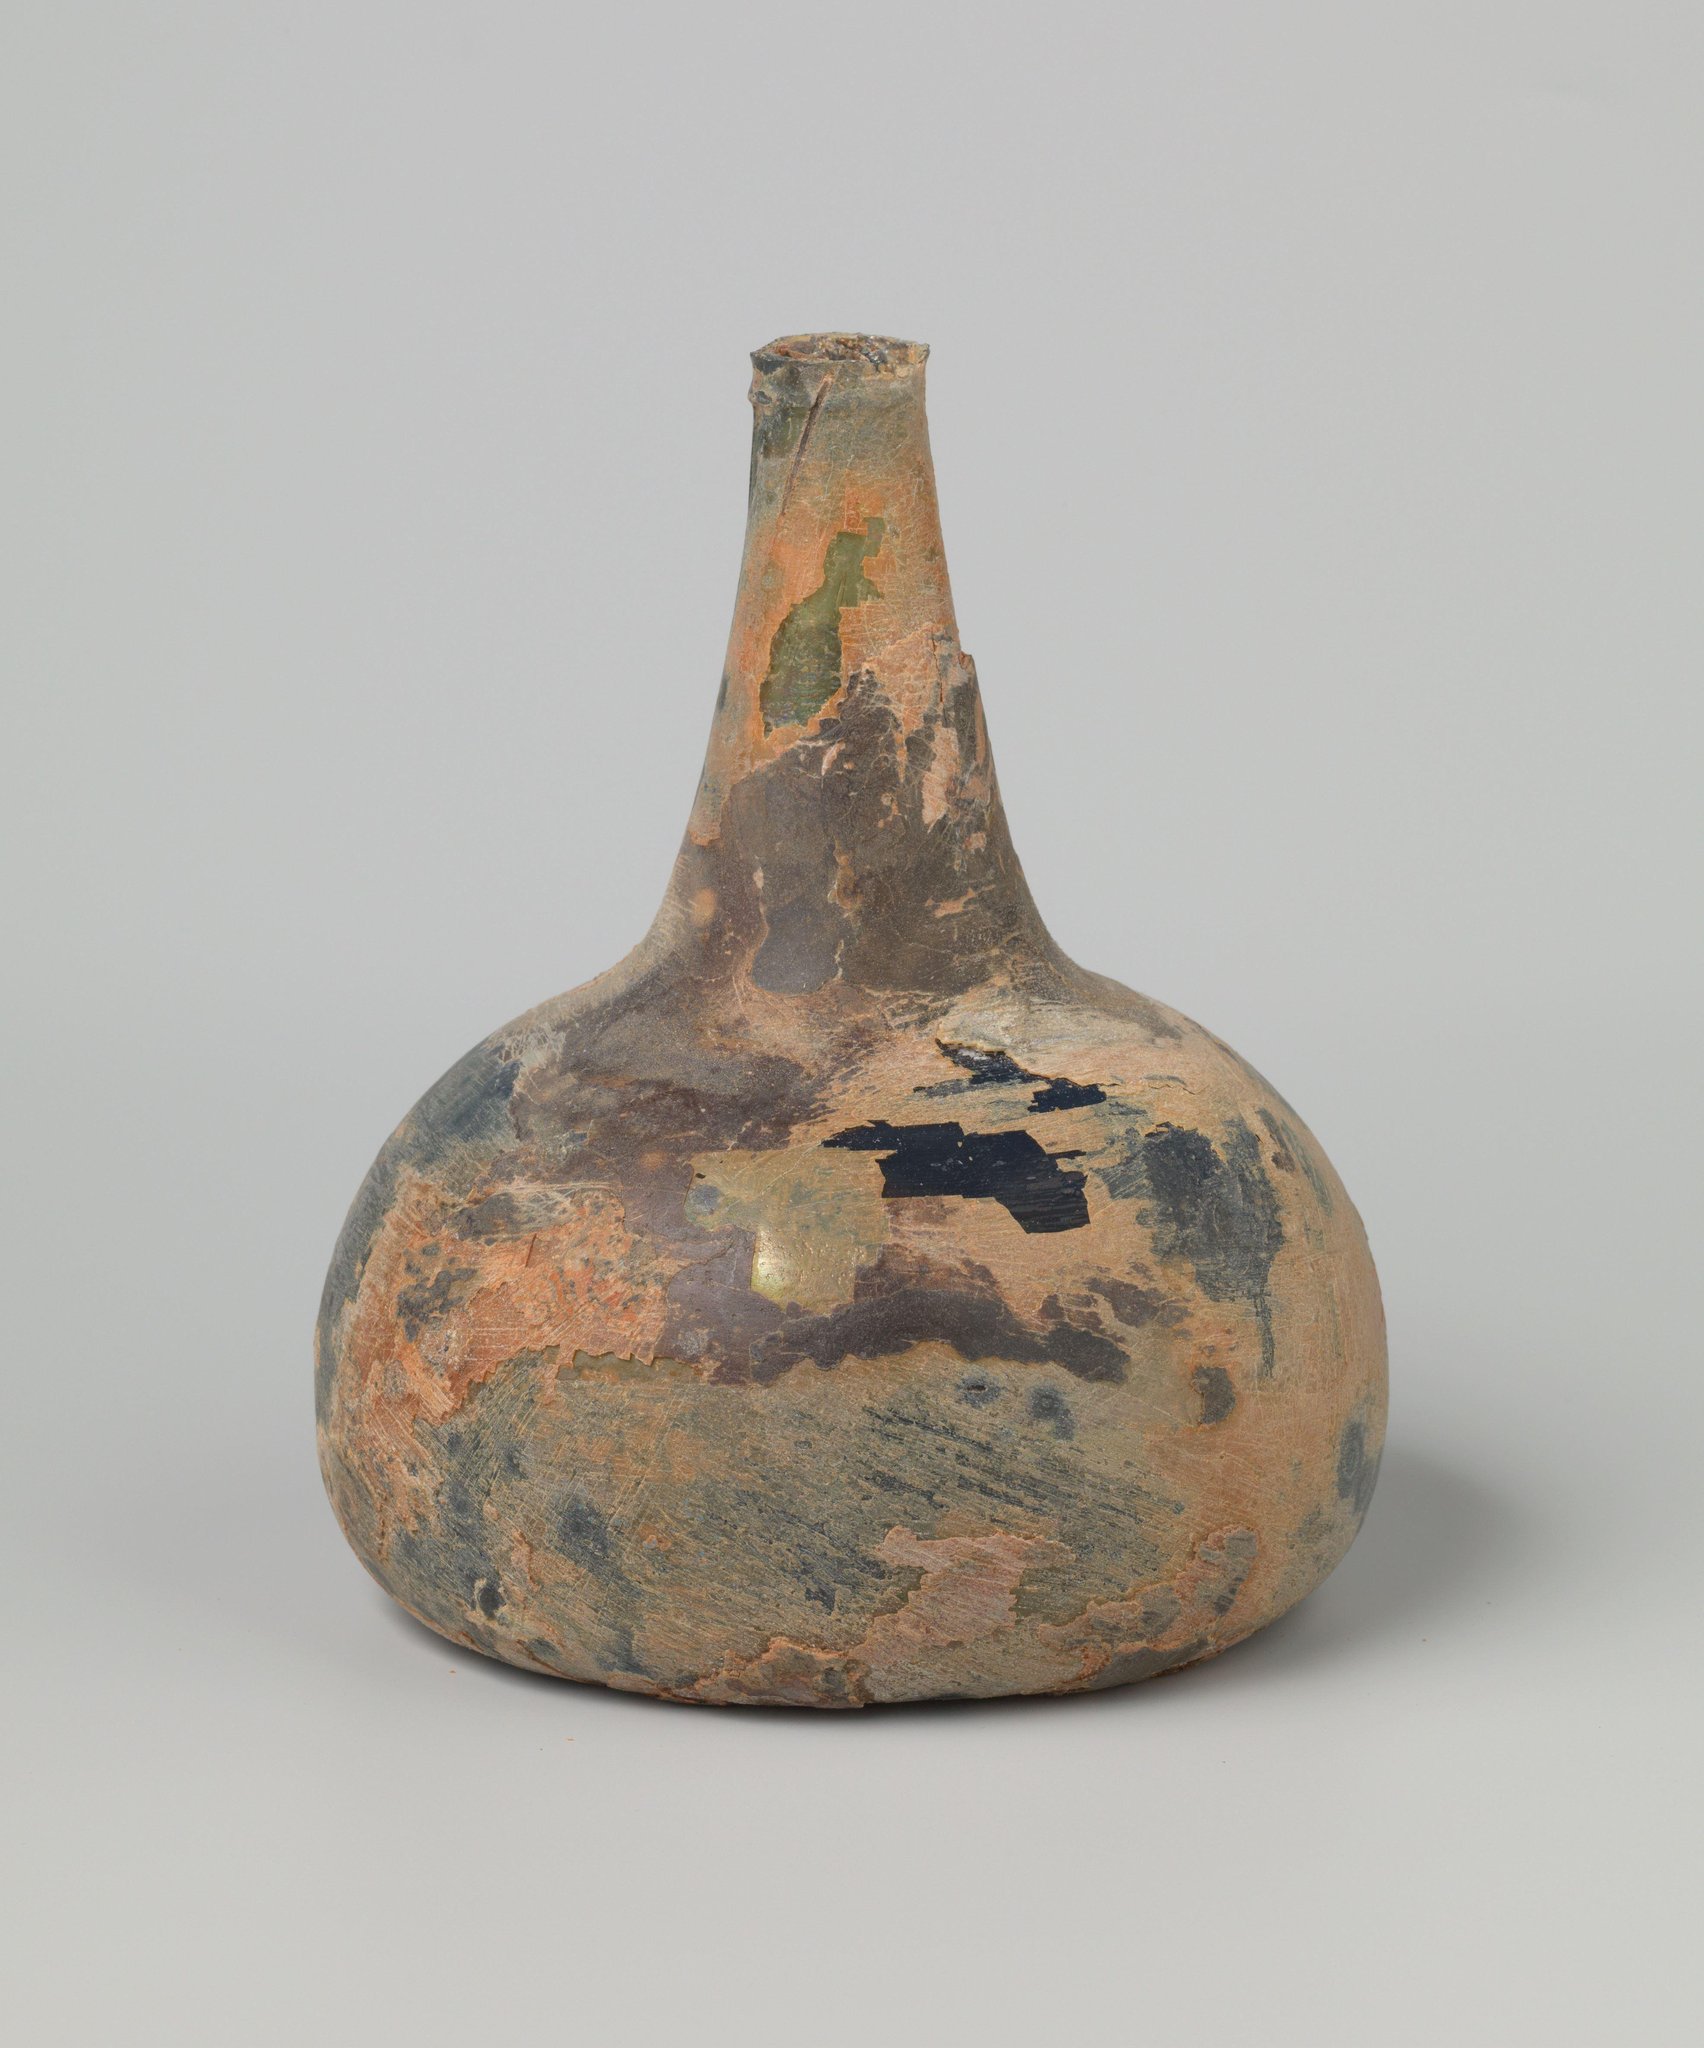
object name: wine bottle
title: Wijnfles uit het wrak van de Oost-Indiëvaarder Hollandia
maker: Anonymous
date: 1700-1743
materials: glass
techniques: green glass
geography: netherlands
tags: verenigde oostindische compagnie, hollandia (schip), annet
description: Wine bottle, continental production, onion-shaped, complete; eroded, string rim eroded, tcs-kick-up.